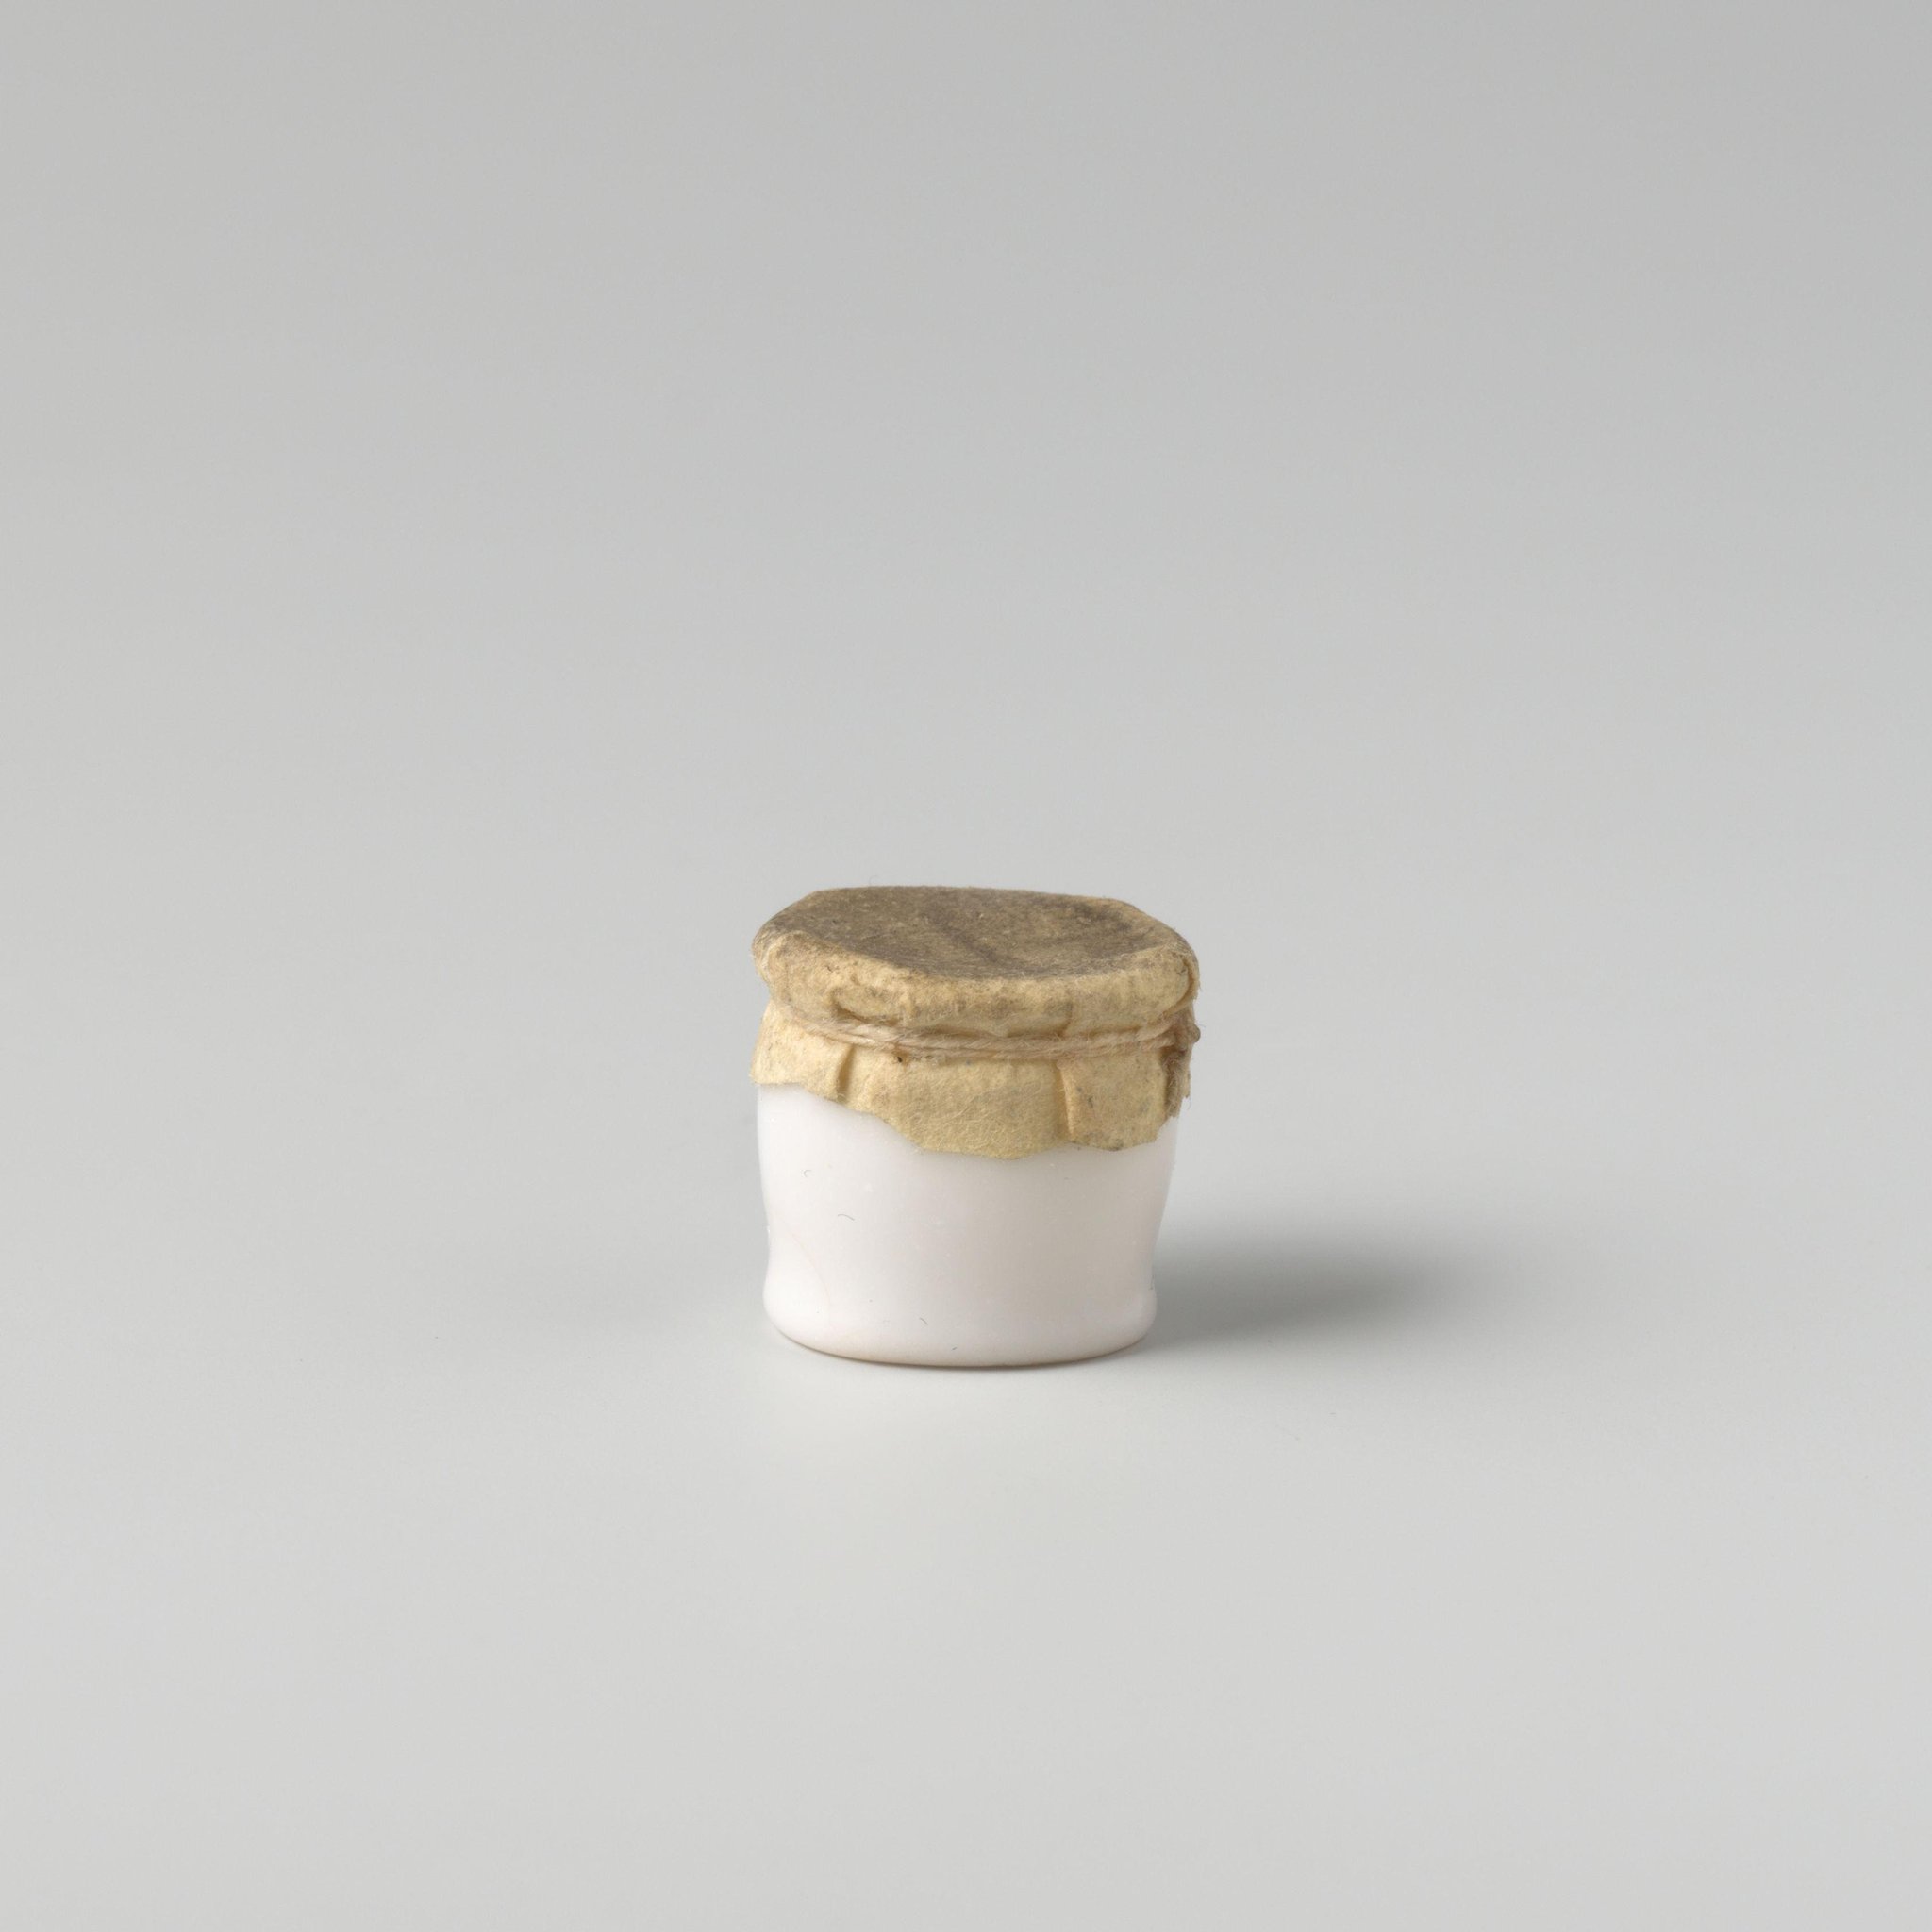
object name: miniature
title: Voorraadpot van opaak wit glas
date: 1675-1700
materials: leather, glass, linen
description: Cilindirsche voorraadpot van opaak wit glas, met naar binnen gestoken bodem en vernauwde hals. De pot is afgesloten met een stuk zeemleer en linnen draad.